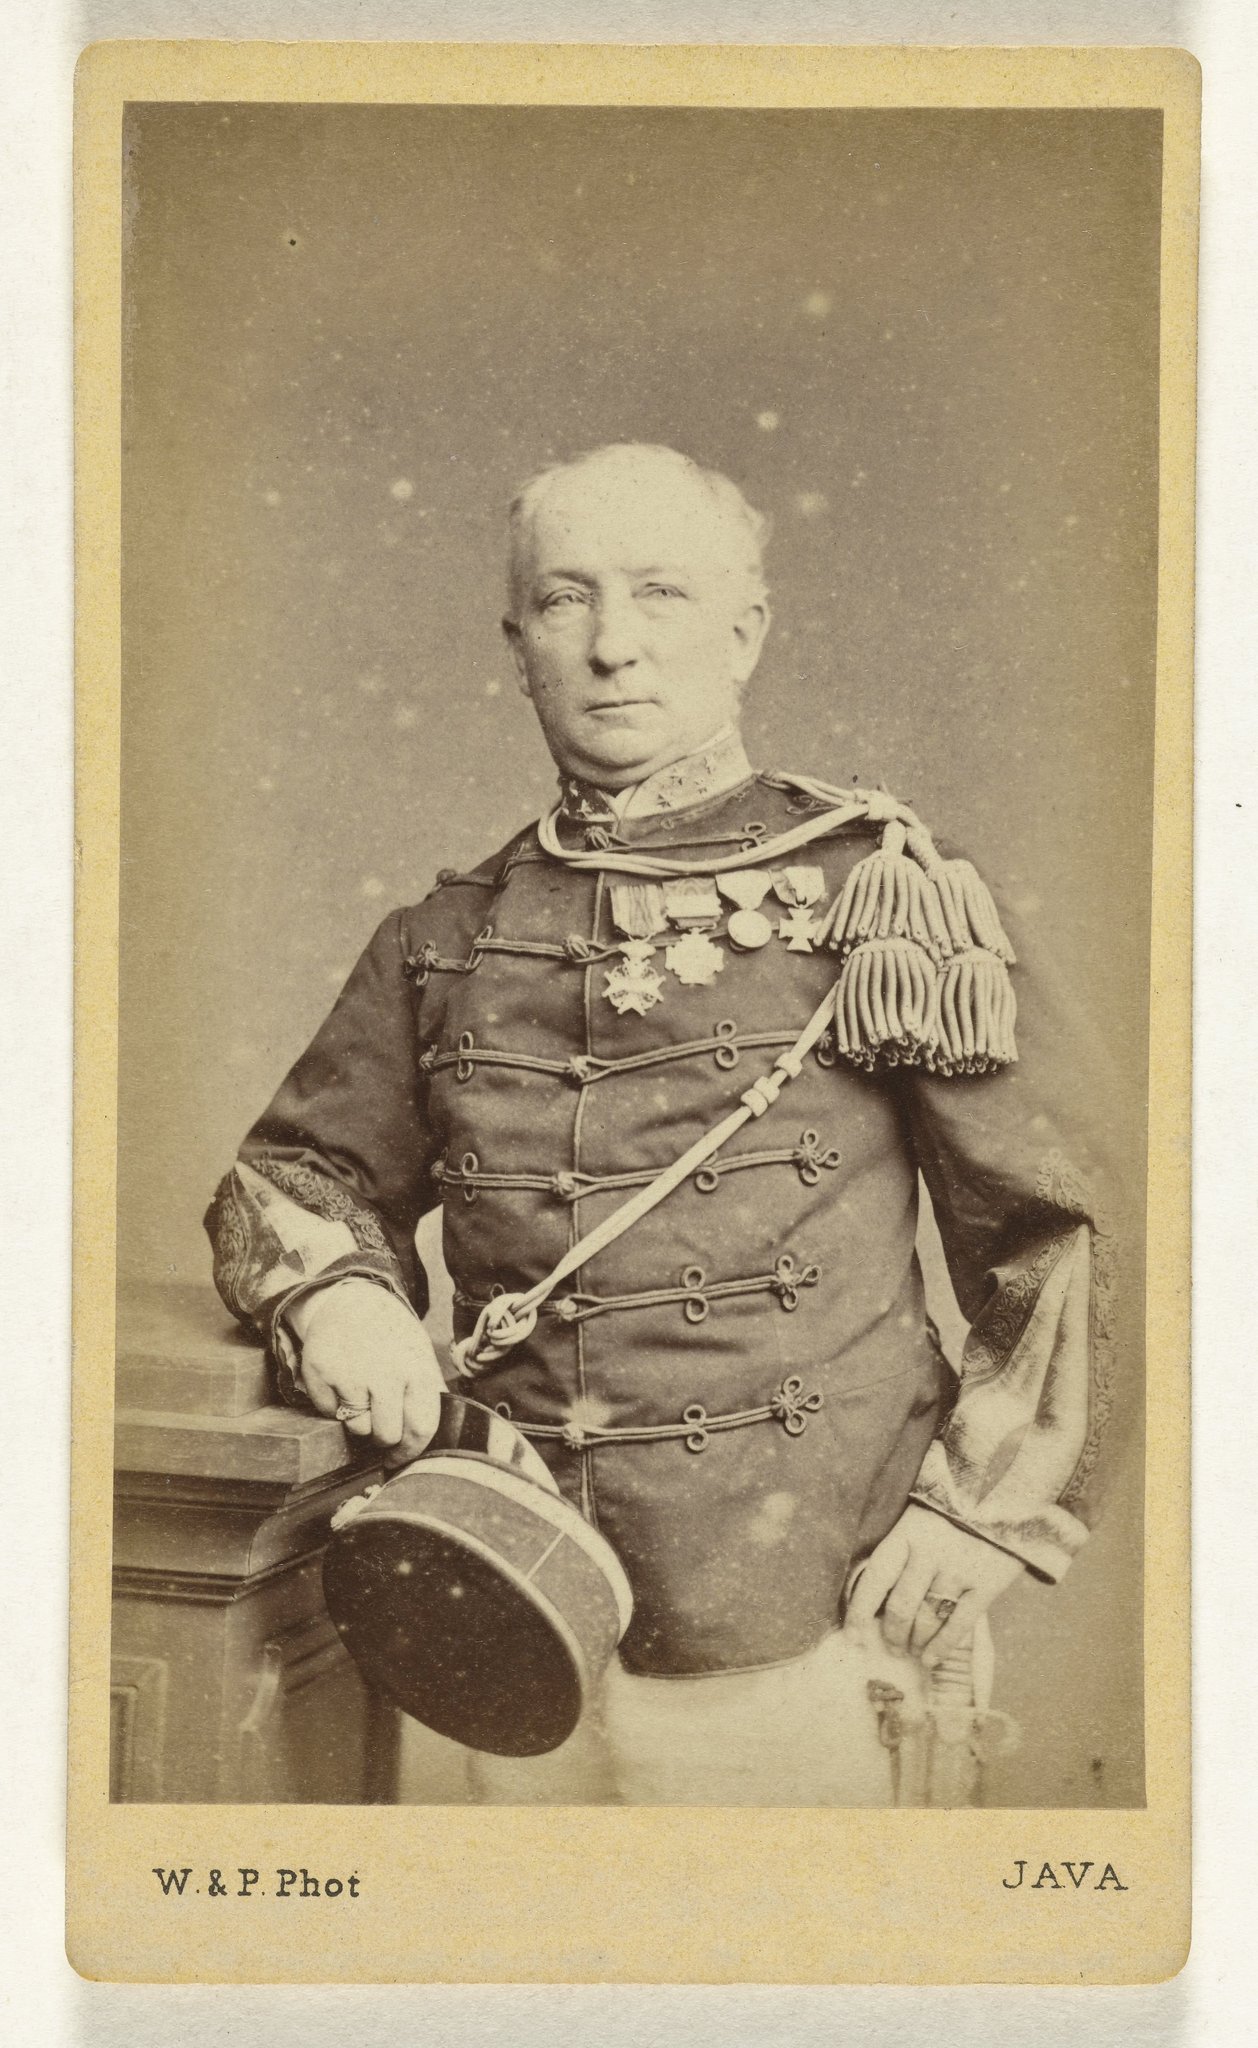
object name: photograph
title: Studioportret van Generaal-Majoor G.B.T. Wiggers van Kerchem met onder andere zijn Militaire Willemsorde, met kepi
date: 1870-1890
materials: paper, photographic support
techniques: photography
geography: java